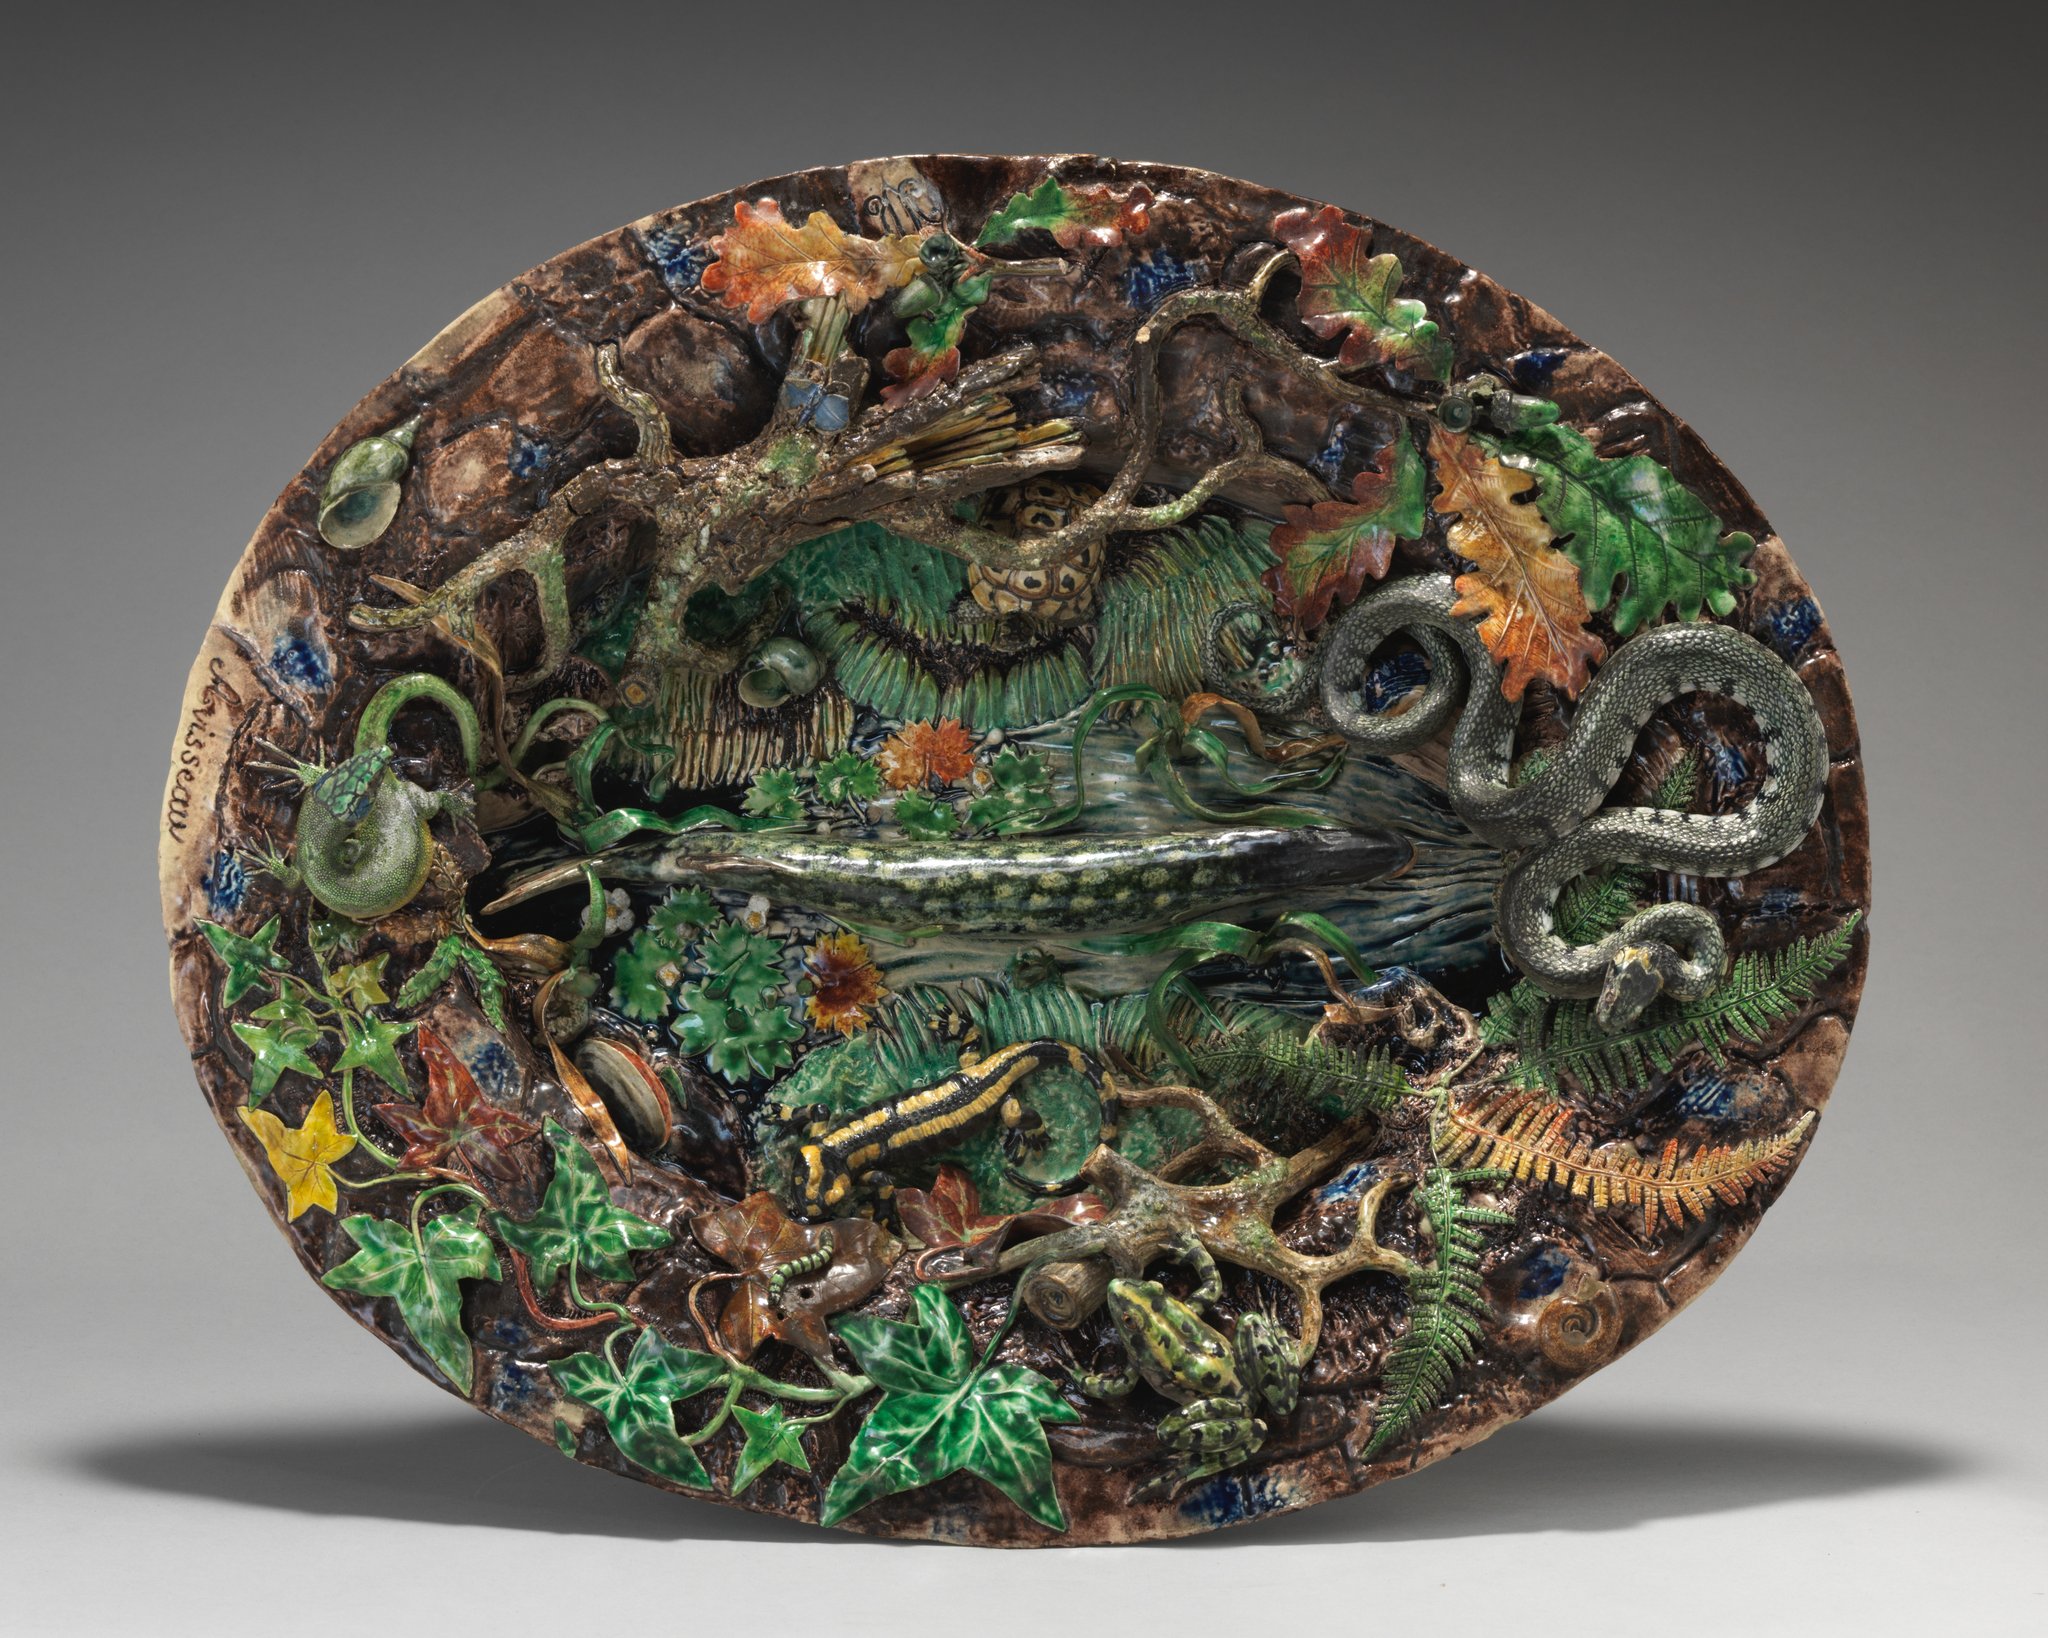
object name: platter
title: Medium oval basin with fish, bark, and fall leaves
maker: charles-jean avisseau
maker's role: maker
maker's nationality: french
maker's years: 1796-1861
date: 1850-1855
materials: earthenware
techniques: glazing